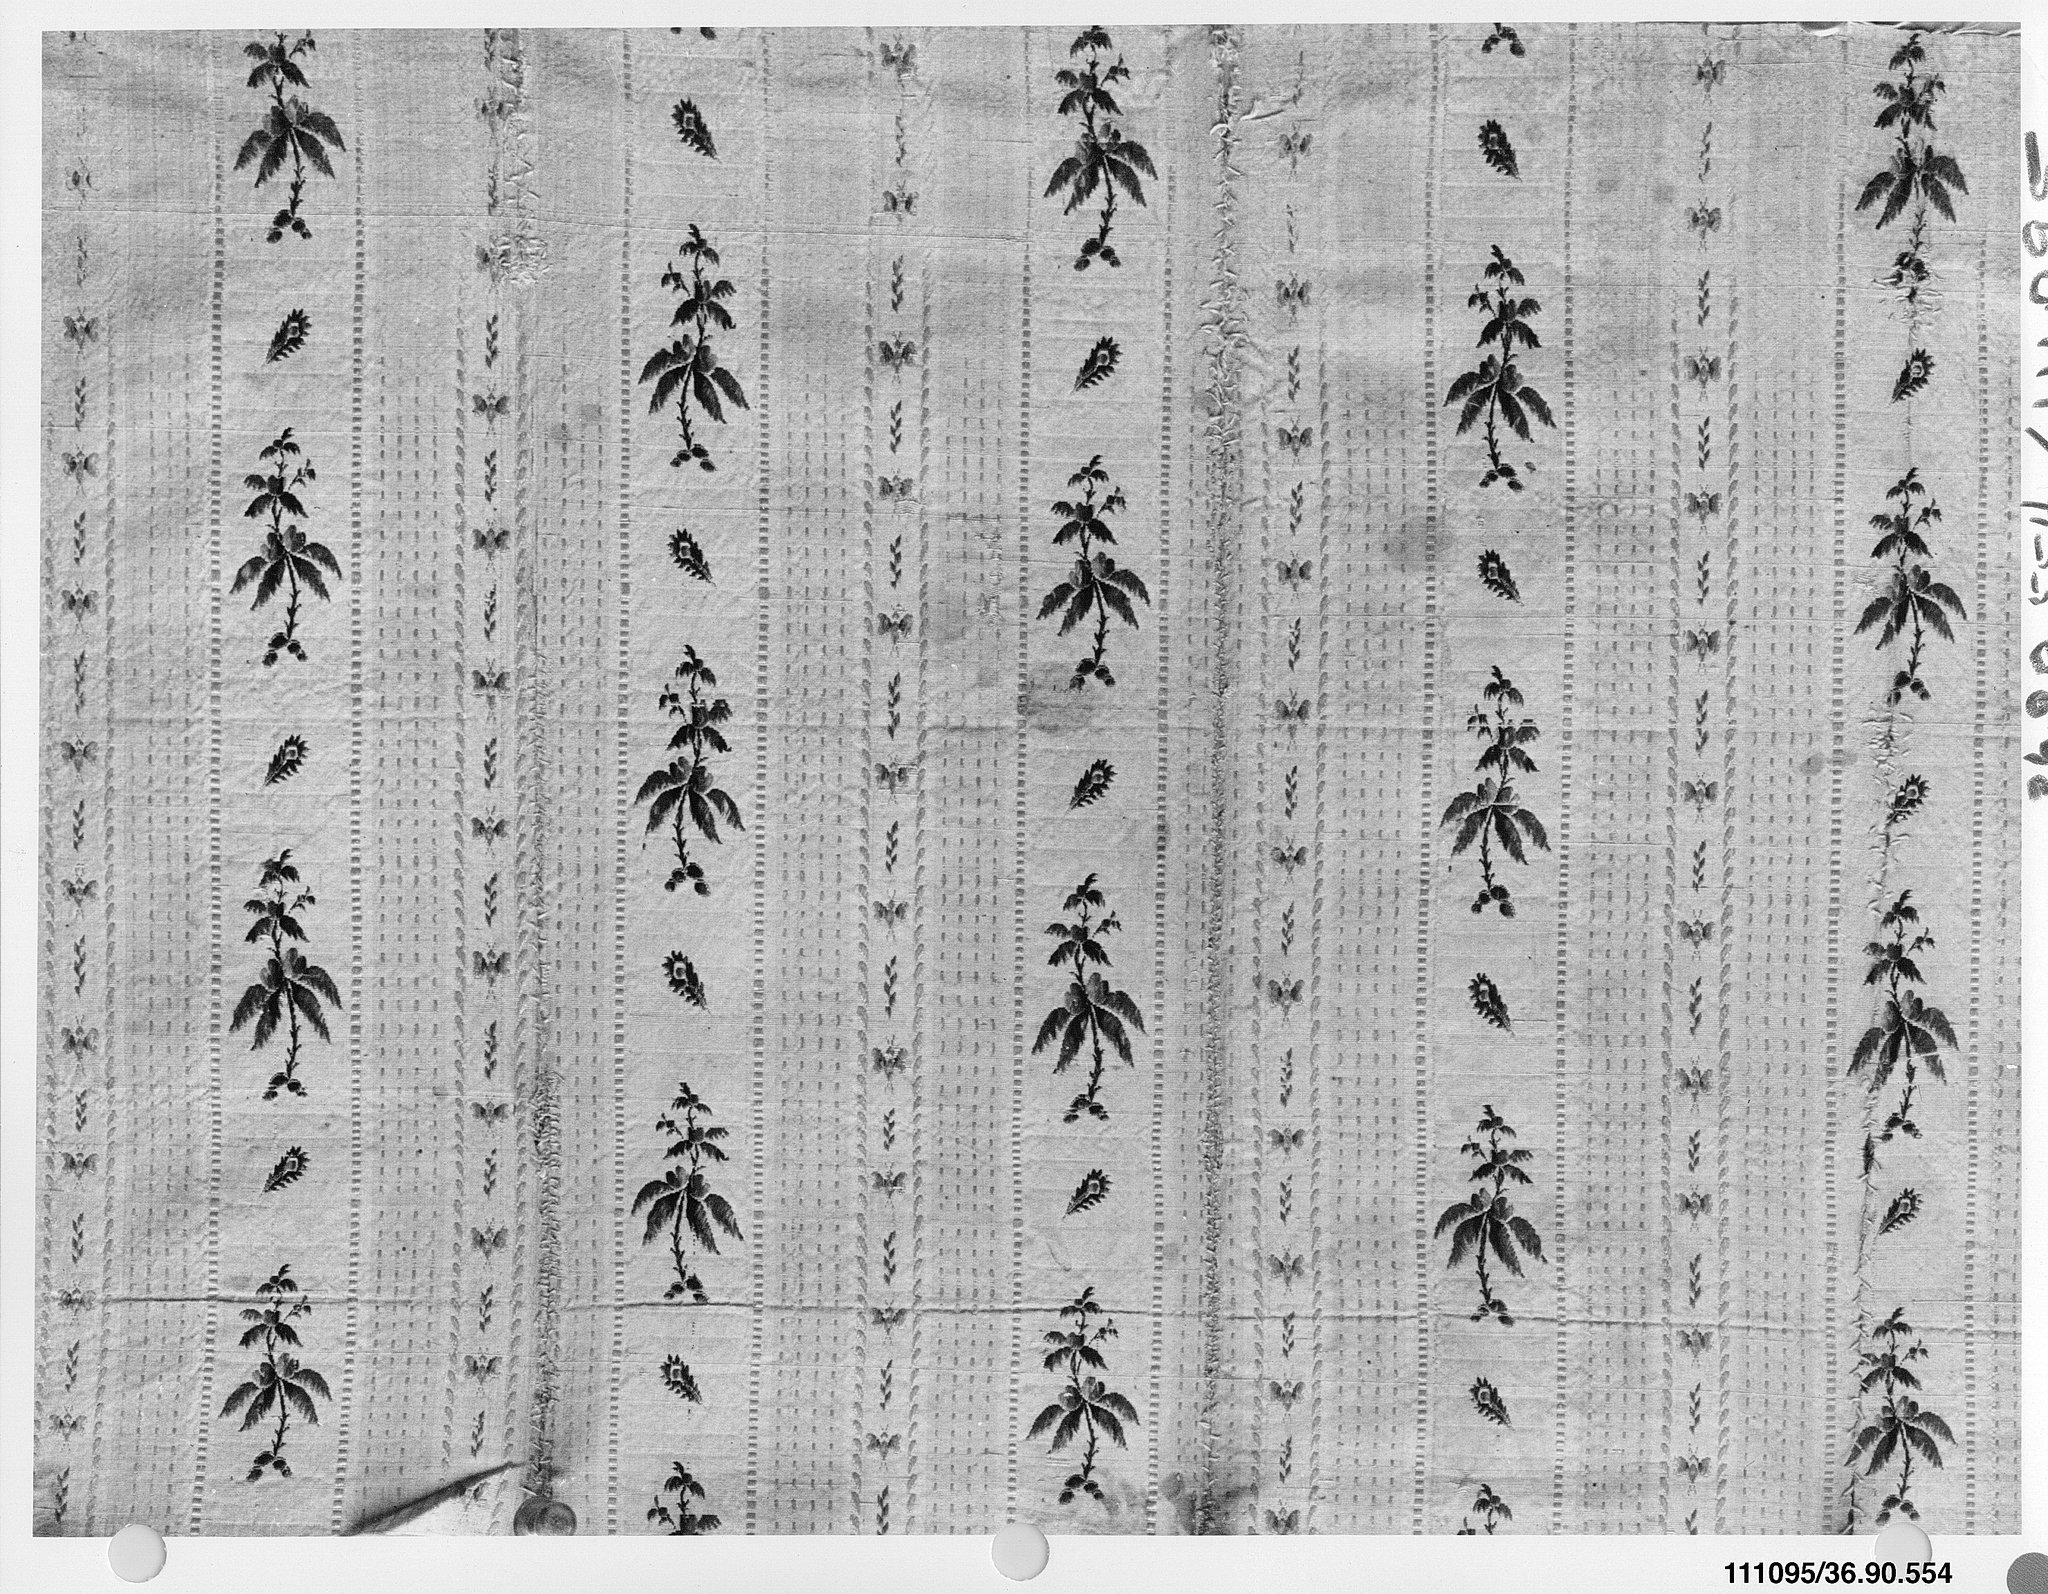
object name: piece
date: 1701-1800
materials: silk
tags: leaves